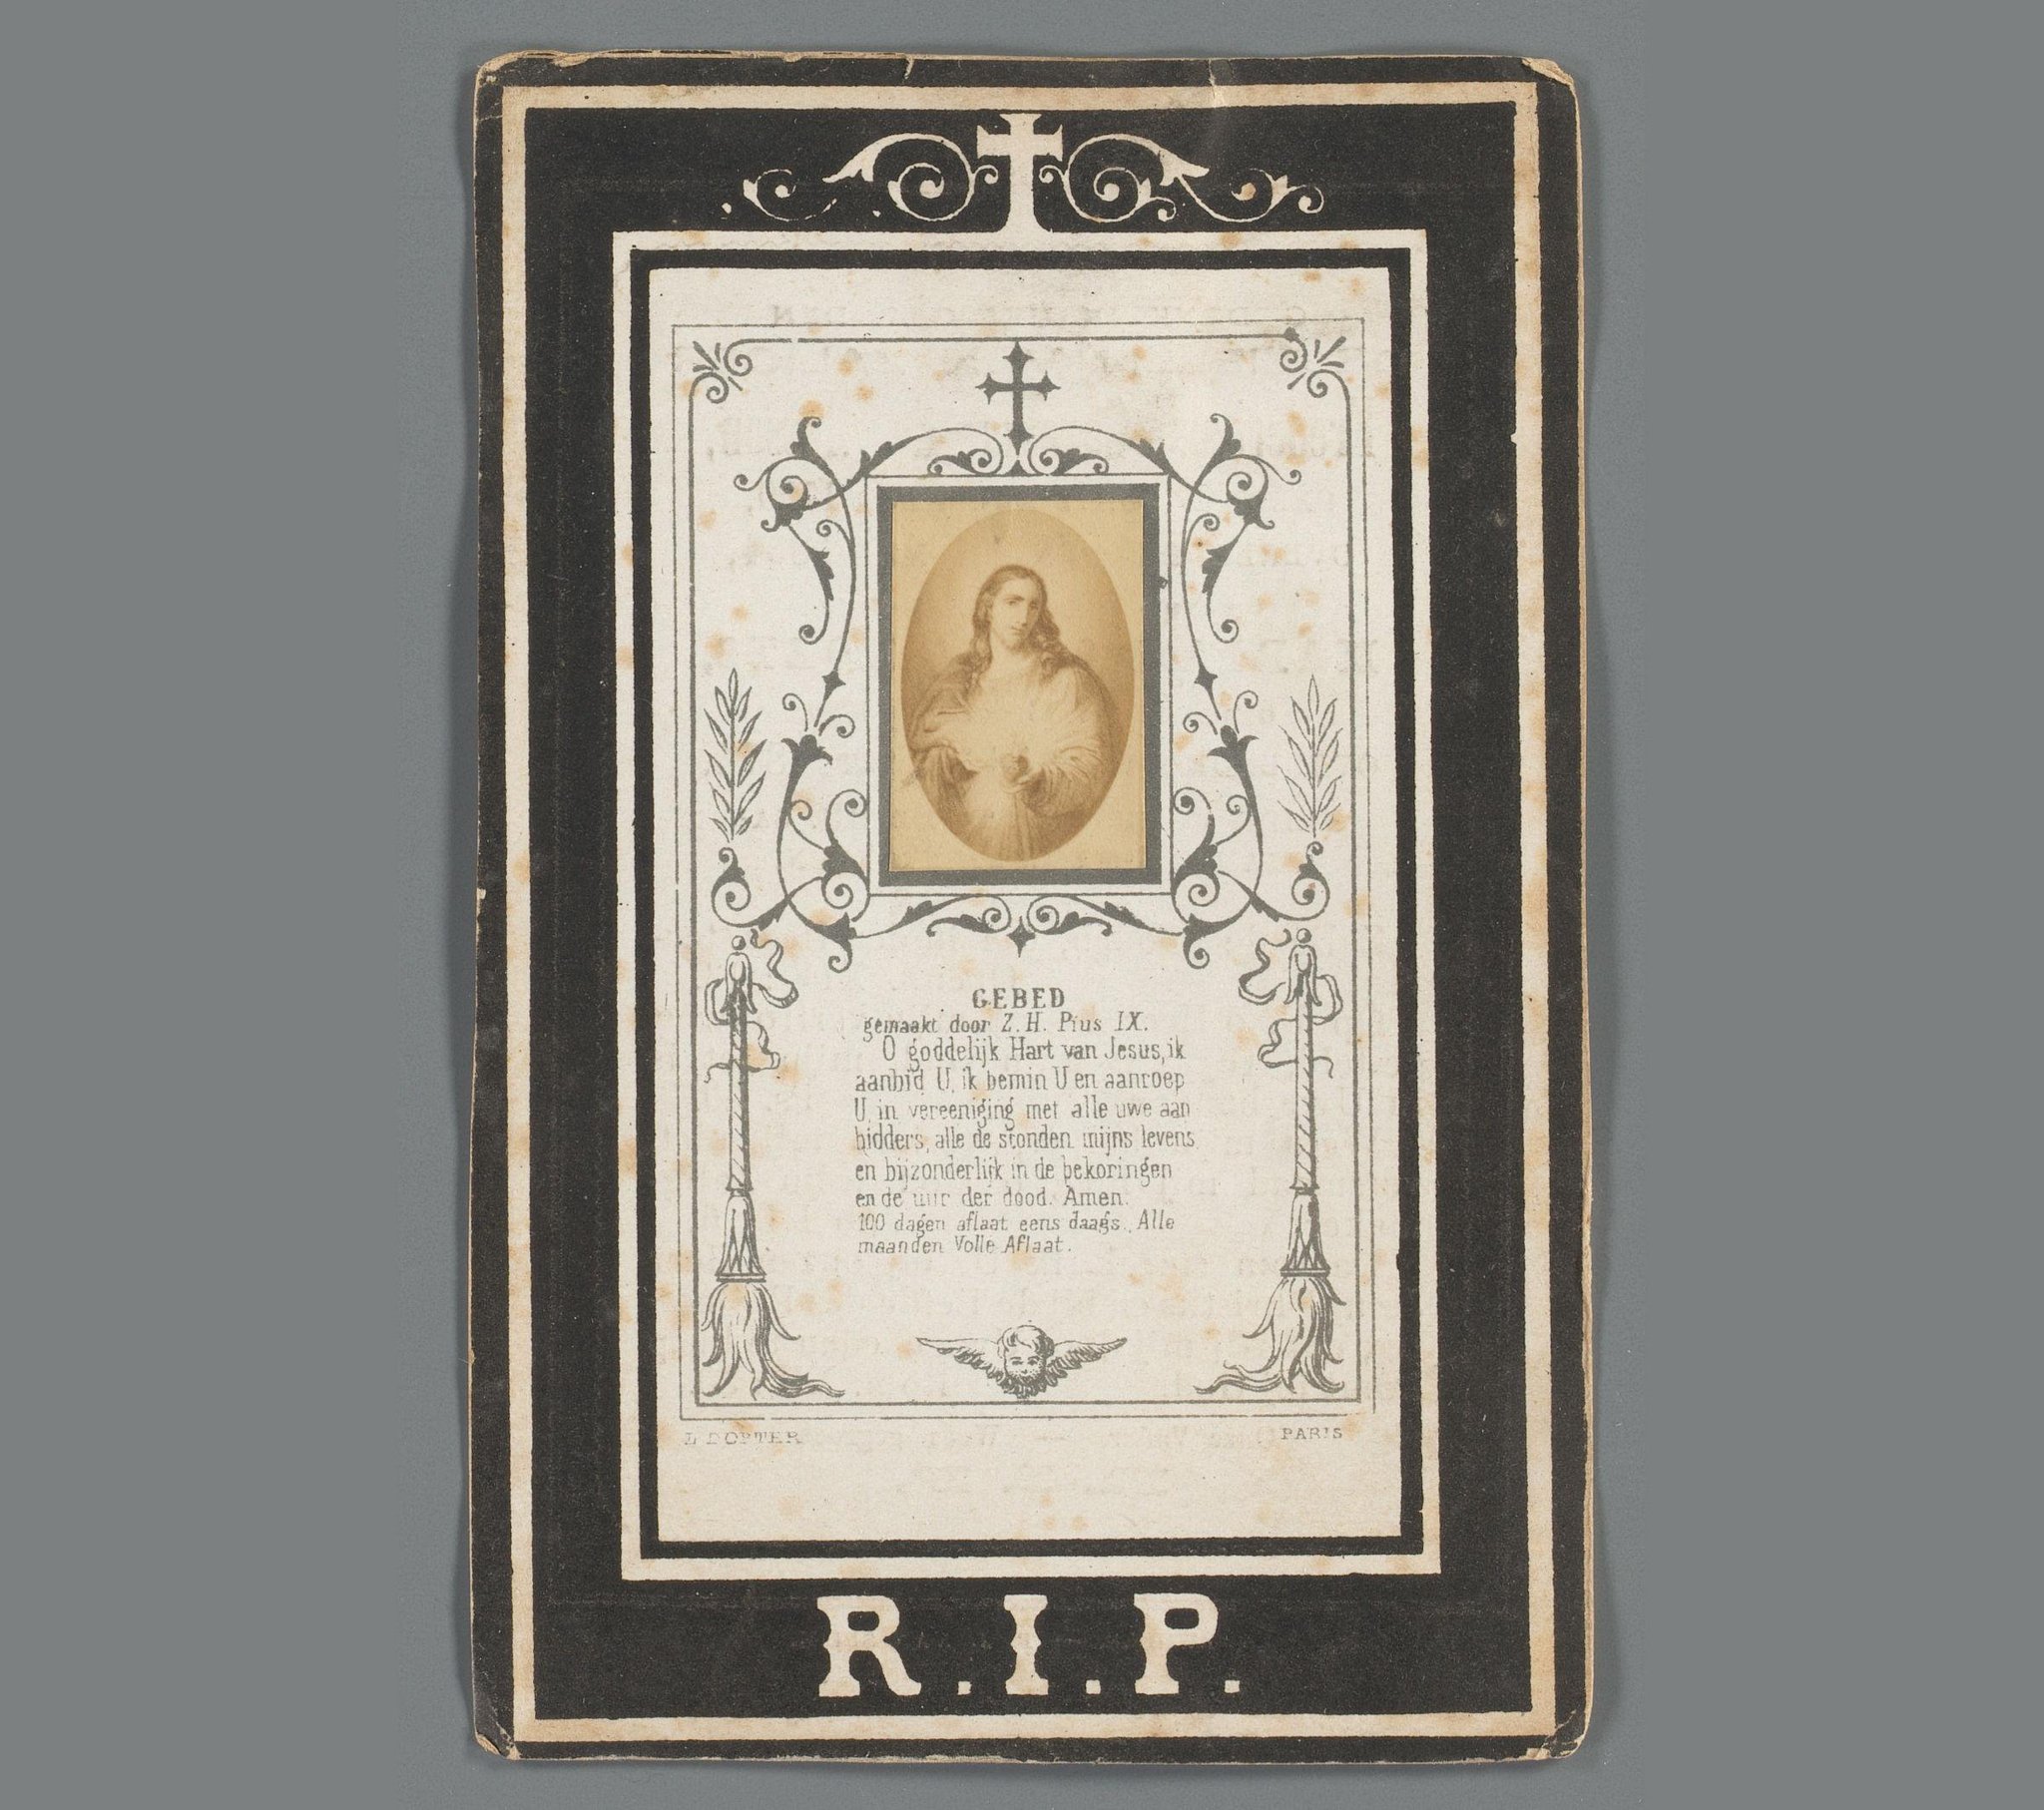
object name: reproduction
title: Bidprent ter nagedachtenis van Fredericus Carolus de Hosson en zijn echtgenote Maria Monica Koets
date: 1874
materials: cardboard, paper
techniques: albumen print, letterpress printing, printing block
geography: groningen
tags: goldsmith, adult woman, the sacred heart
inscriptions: inscription: ‘Ge[denk] (...) Onze Vader. - Wees gegroet./ R.I.P./ Zwolle. - P.J. van Spijk.’, inscription: ‘Gebed/ gemaakt door Z.H. Pius IX. (...) L. Dopter Paris/ R.I.P.’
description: Op de voorzijde van de bidprent is een fotoreproductie van een schilderij van Christus Heilig Hart geplakt; op de achterzijde het fotoportret van Maria Koets.